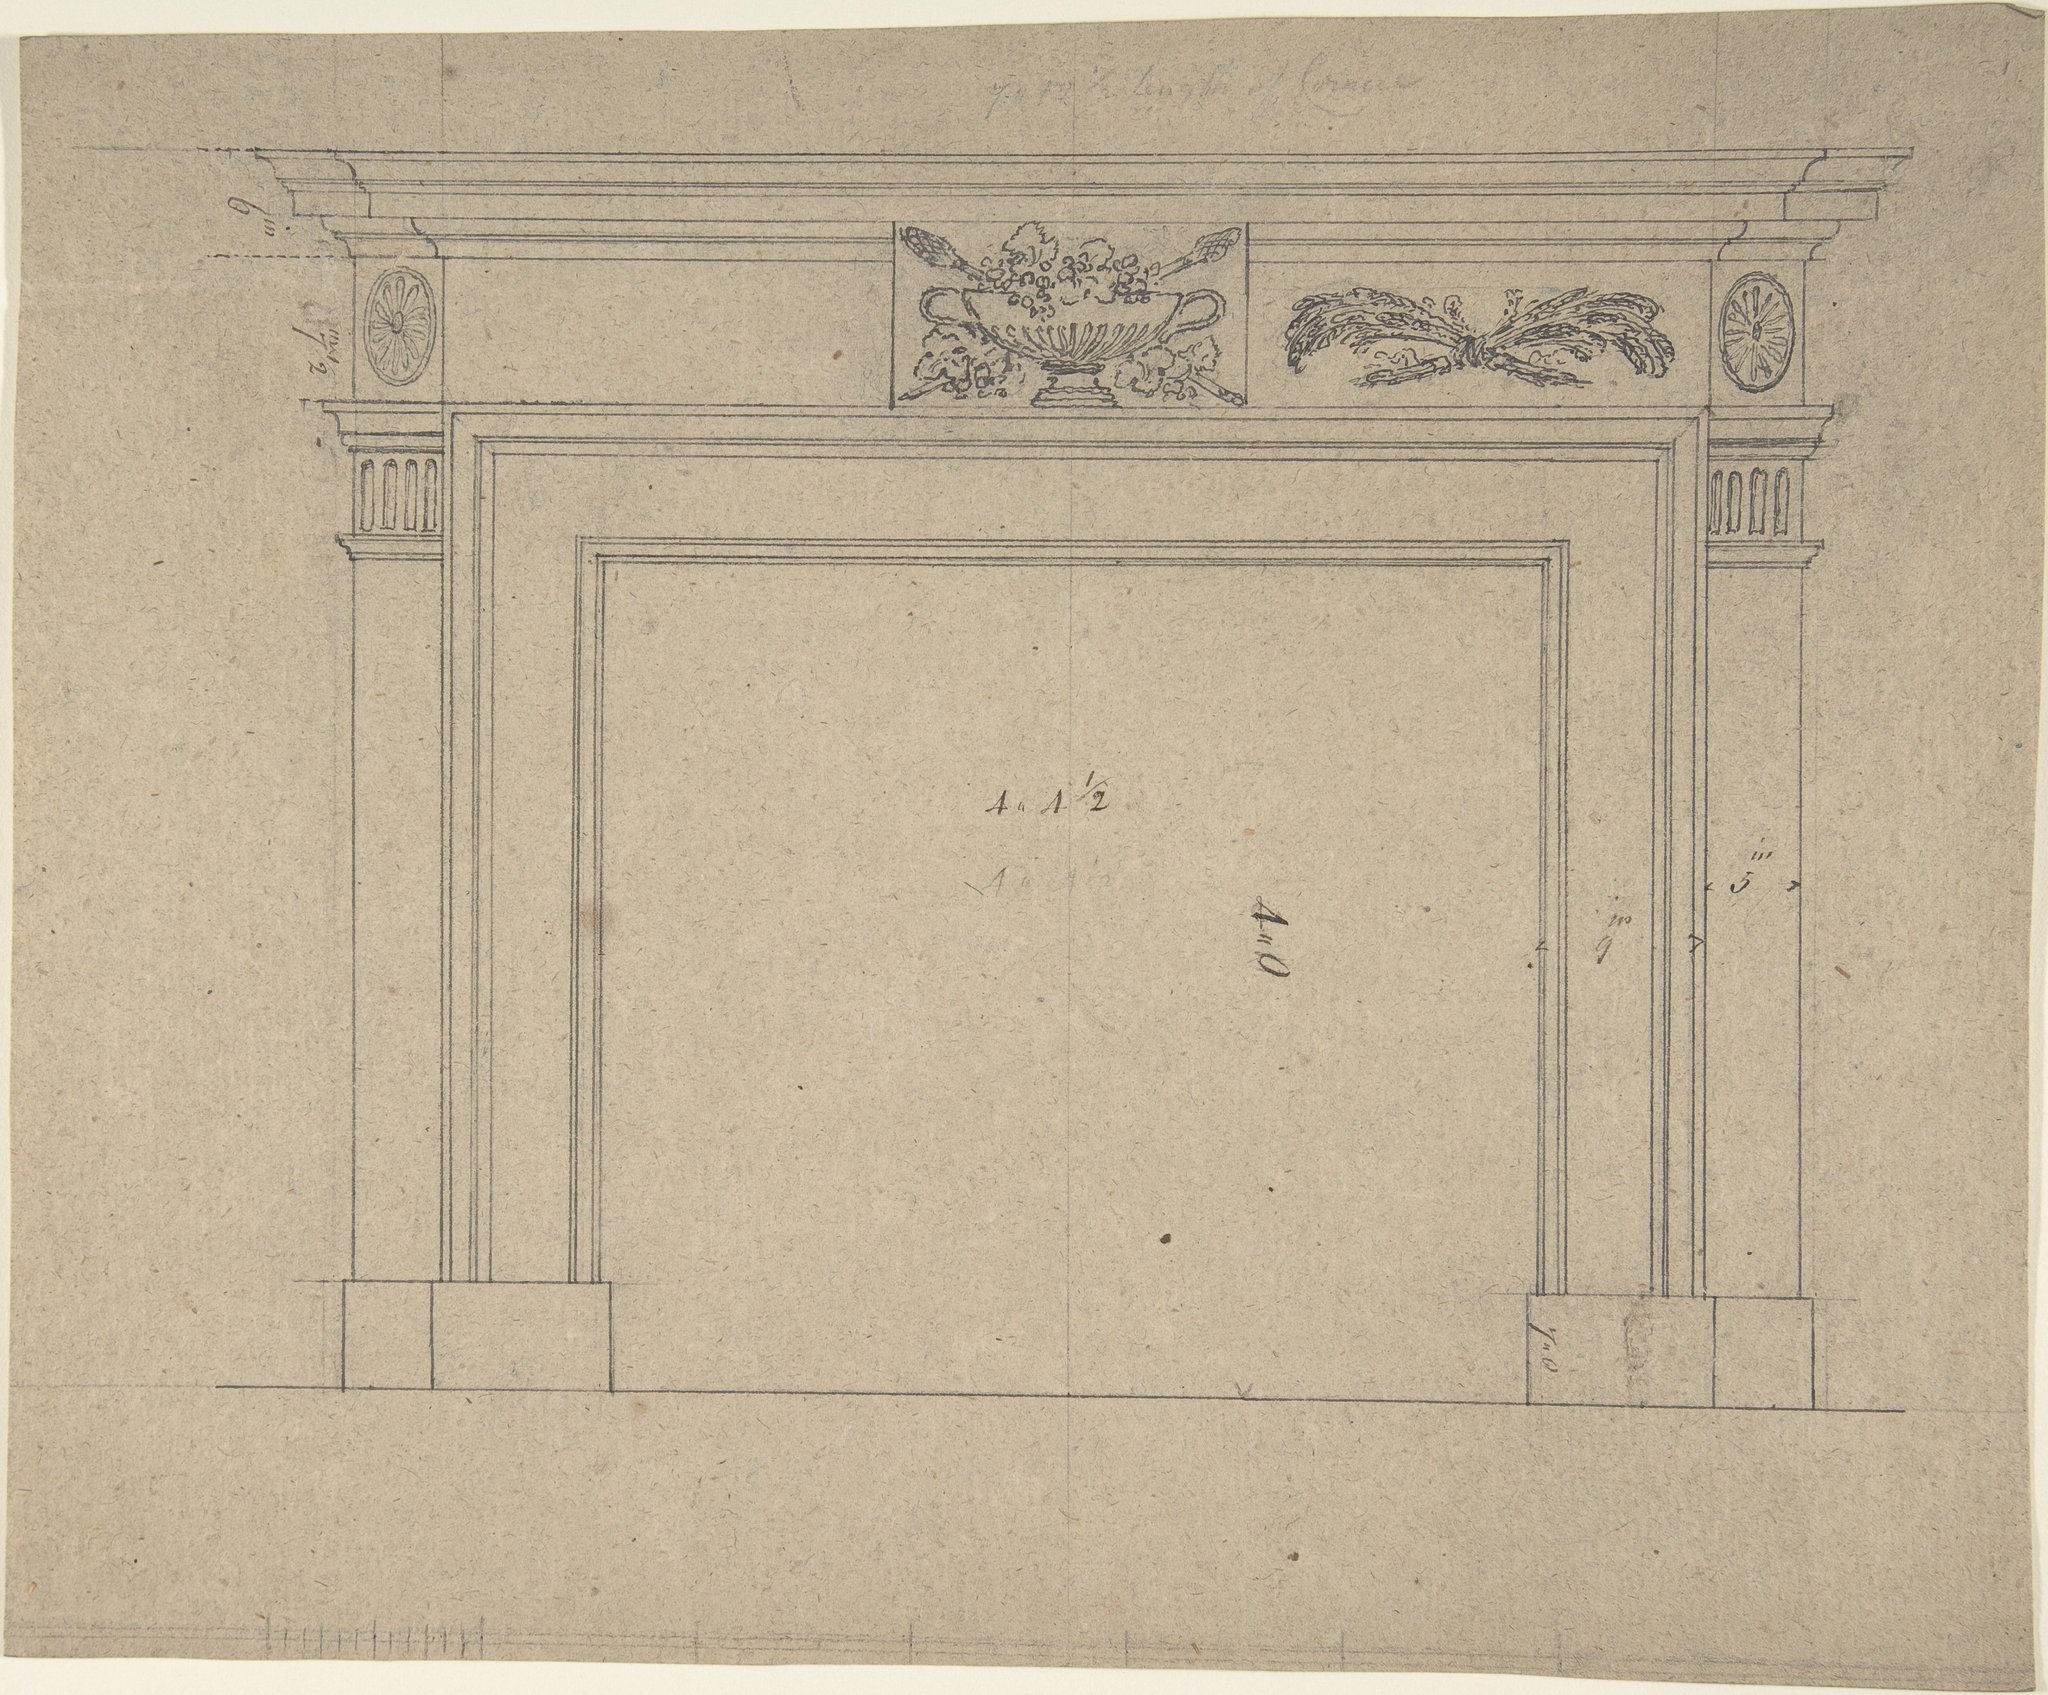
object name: drawing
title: Design for a Chimneypiece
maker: sir william chambers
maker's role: artist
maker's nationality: british, born sweden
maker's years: 1723-1796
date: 1740-1800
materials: ink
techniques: pen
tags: fireplaces,flowers